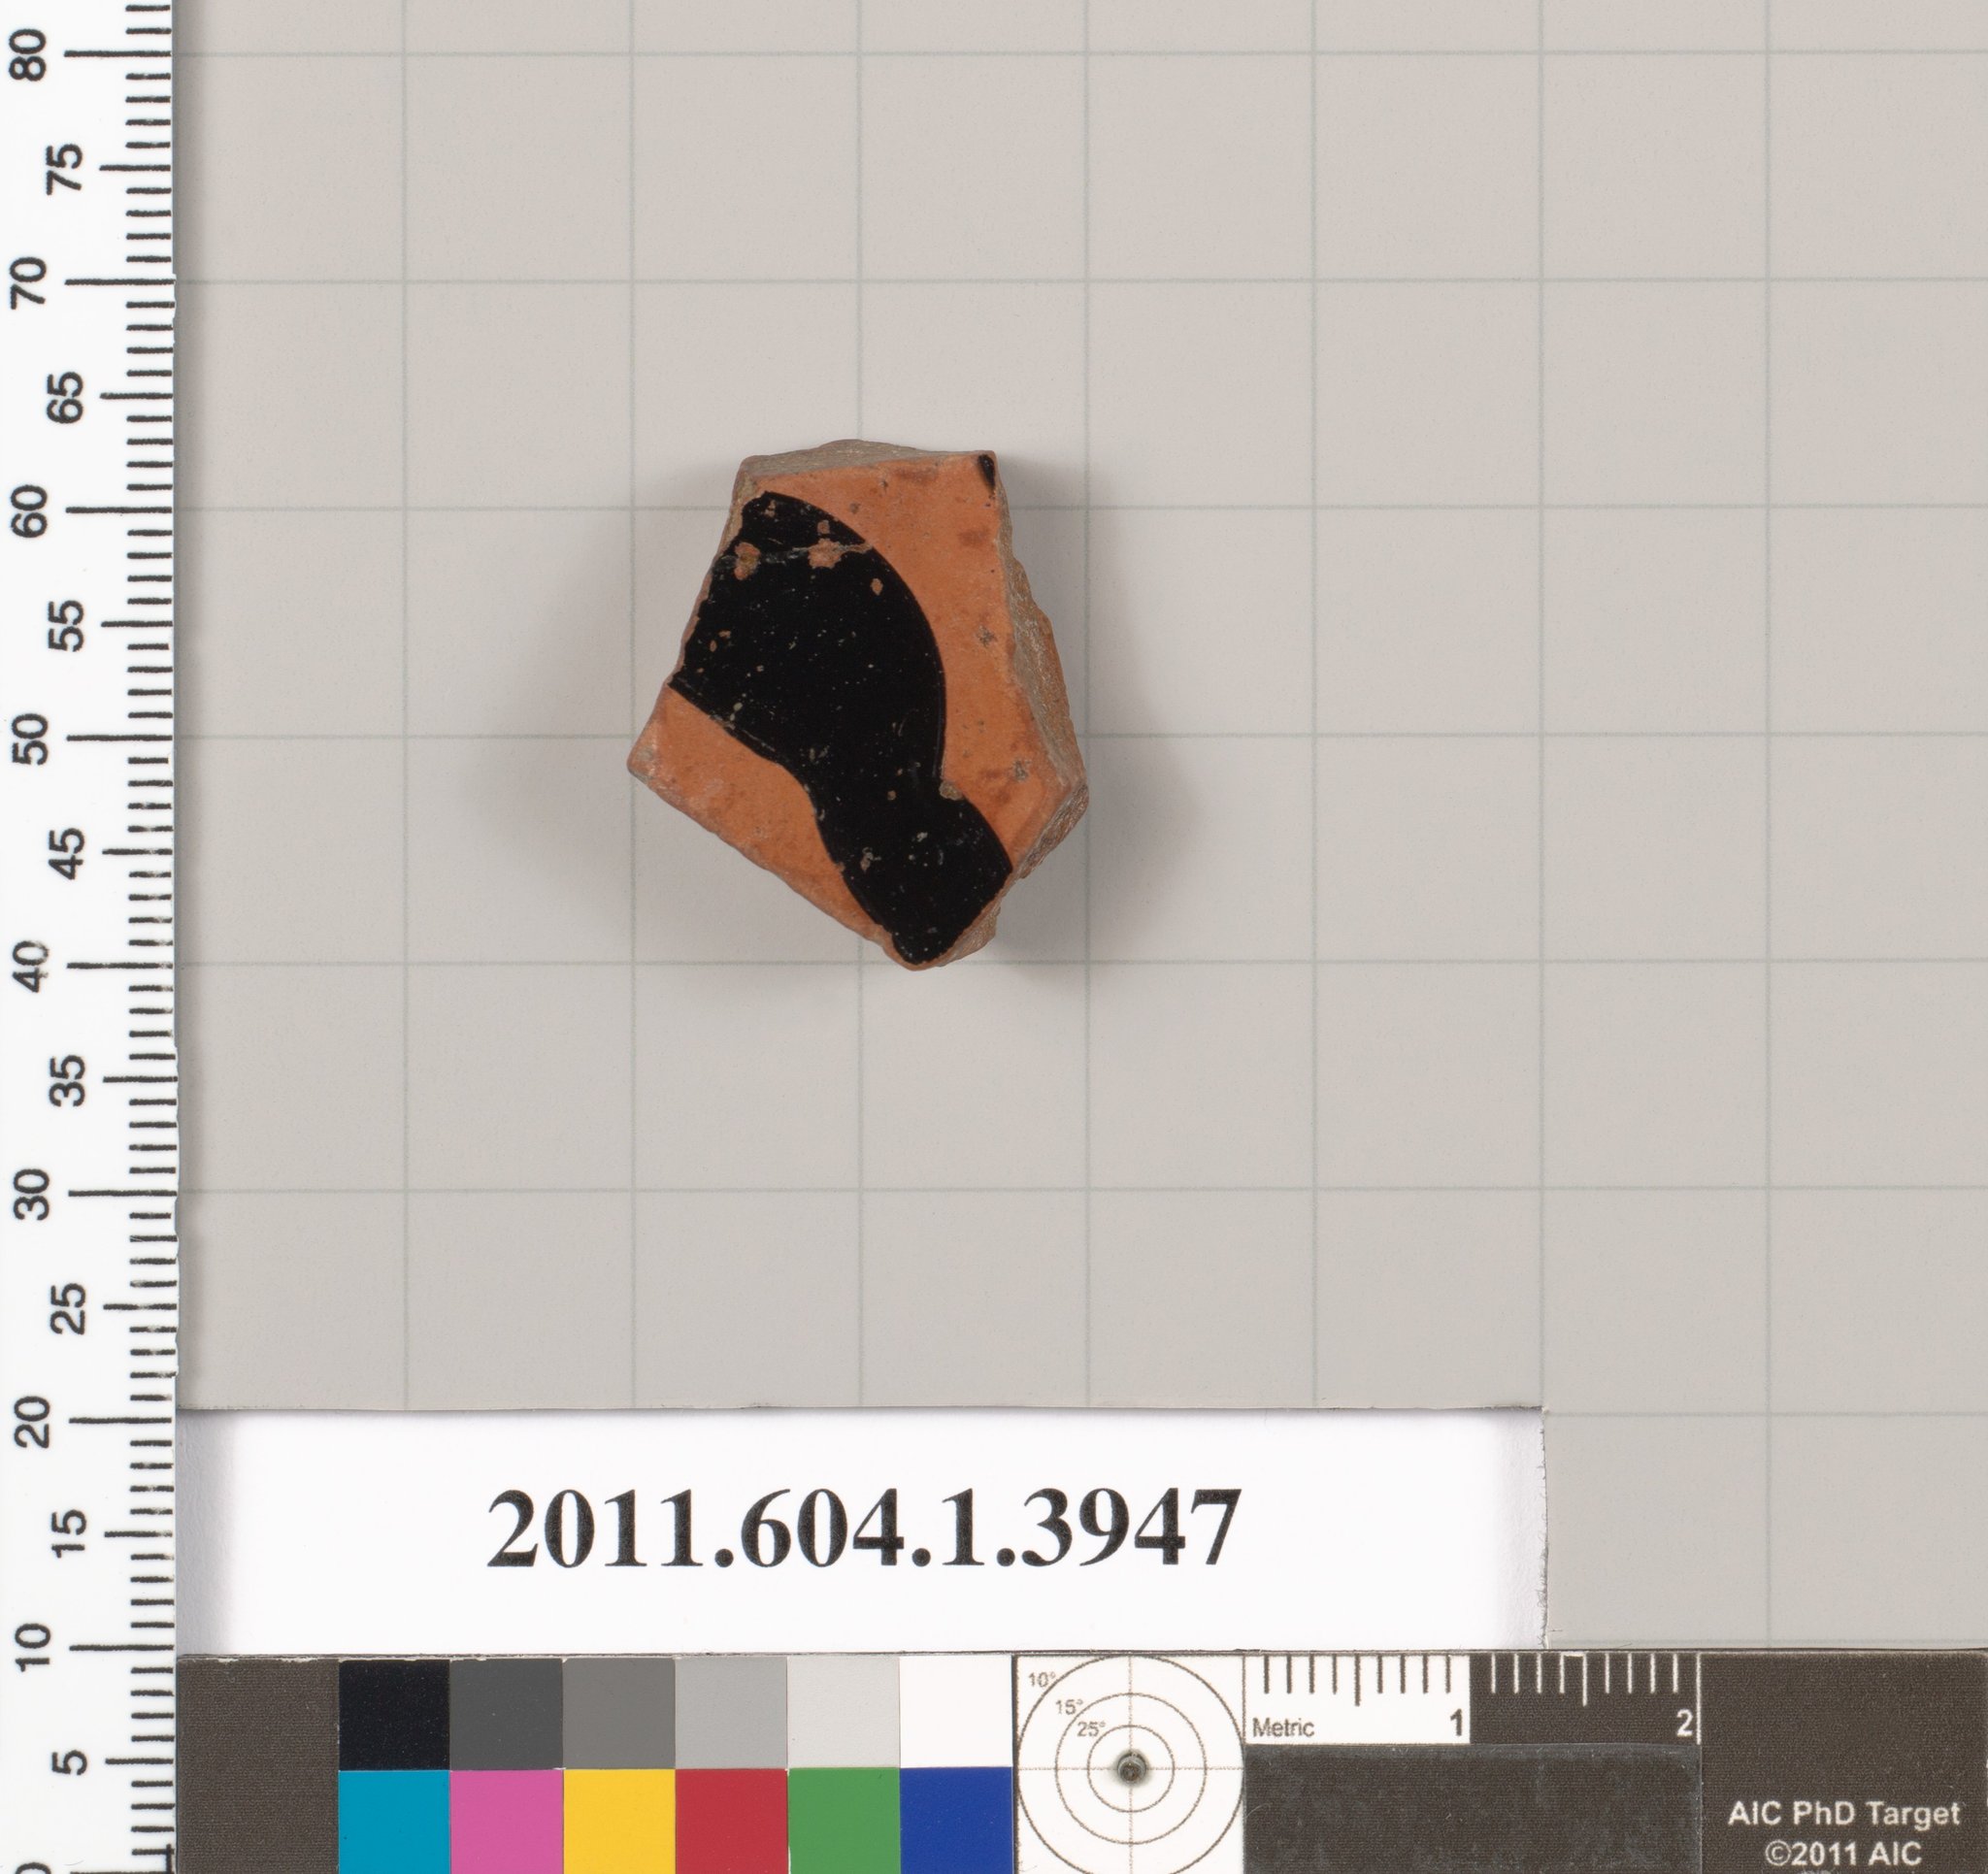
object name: kylix fragment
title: Terracotta fragment of a kylix (drinking cup)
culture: greek, attic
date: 500-451 BCE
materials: terracotta